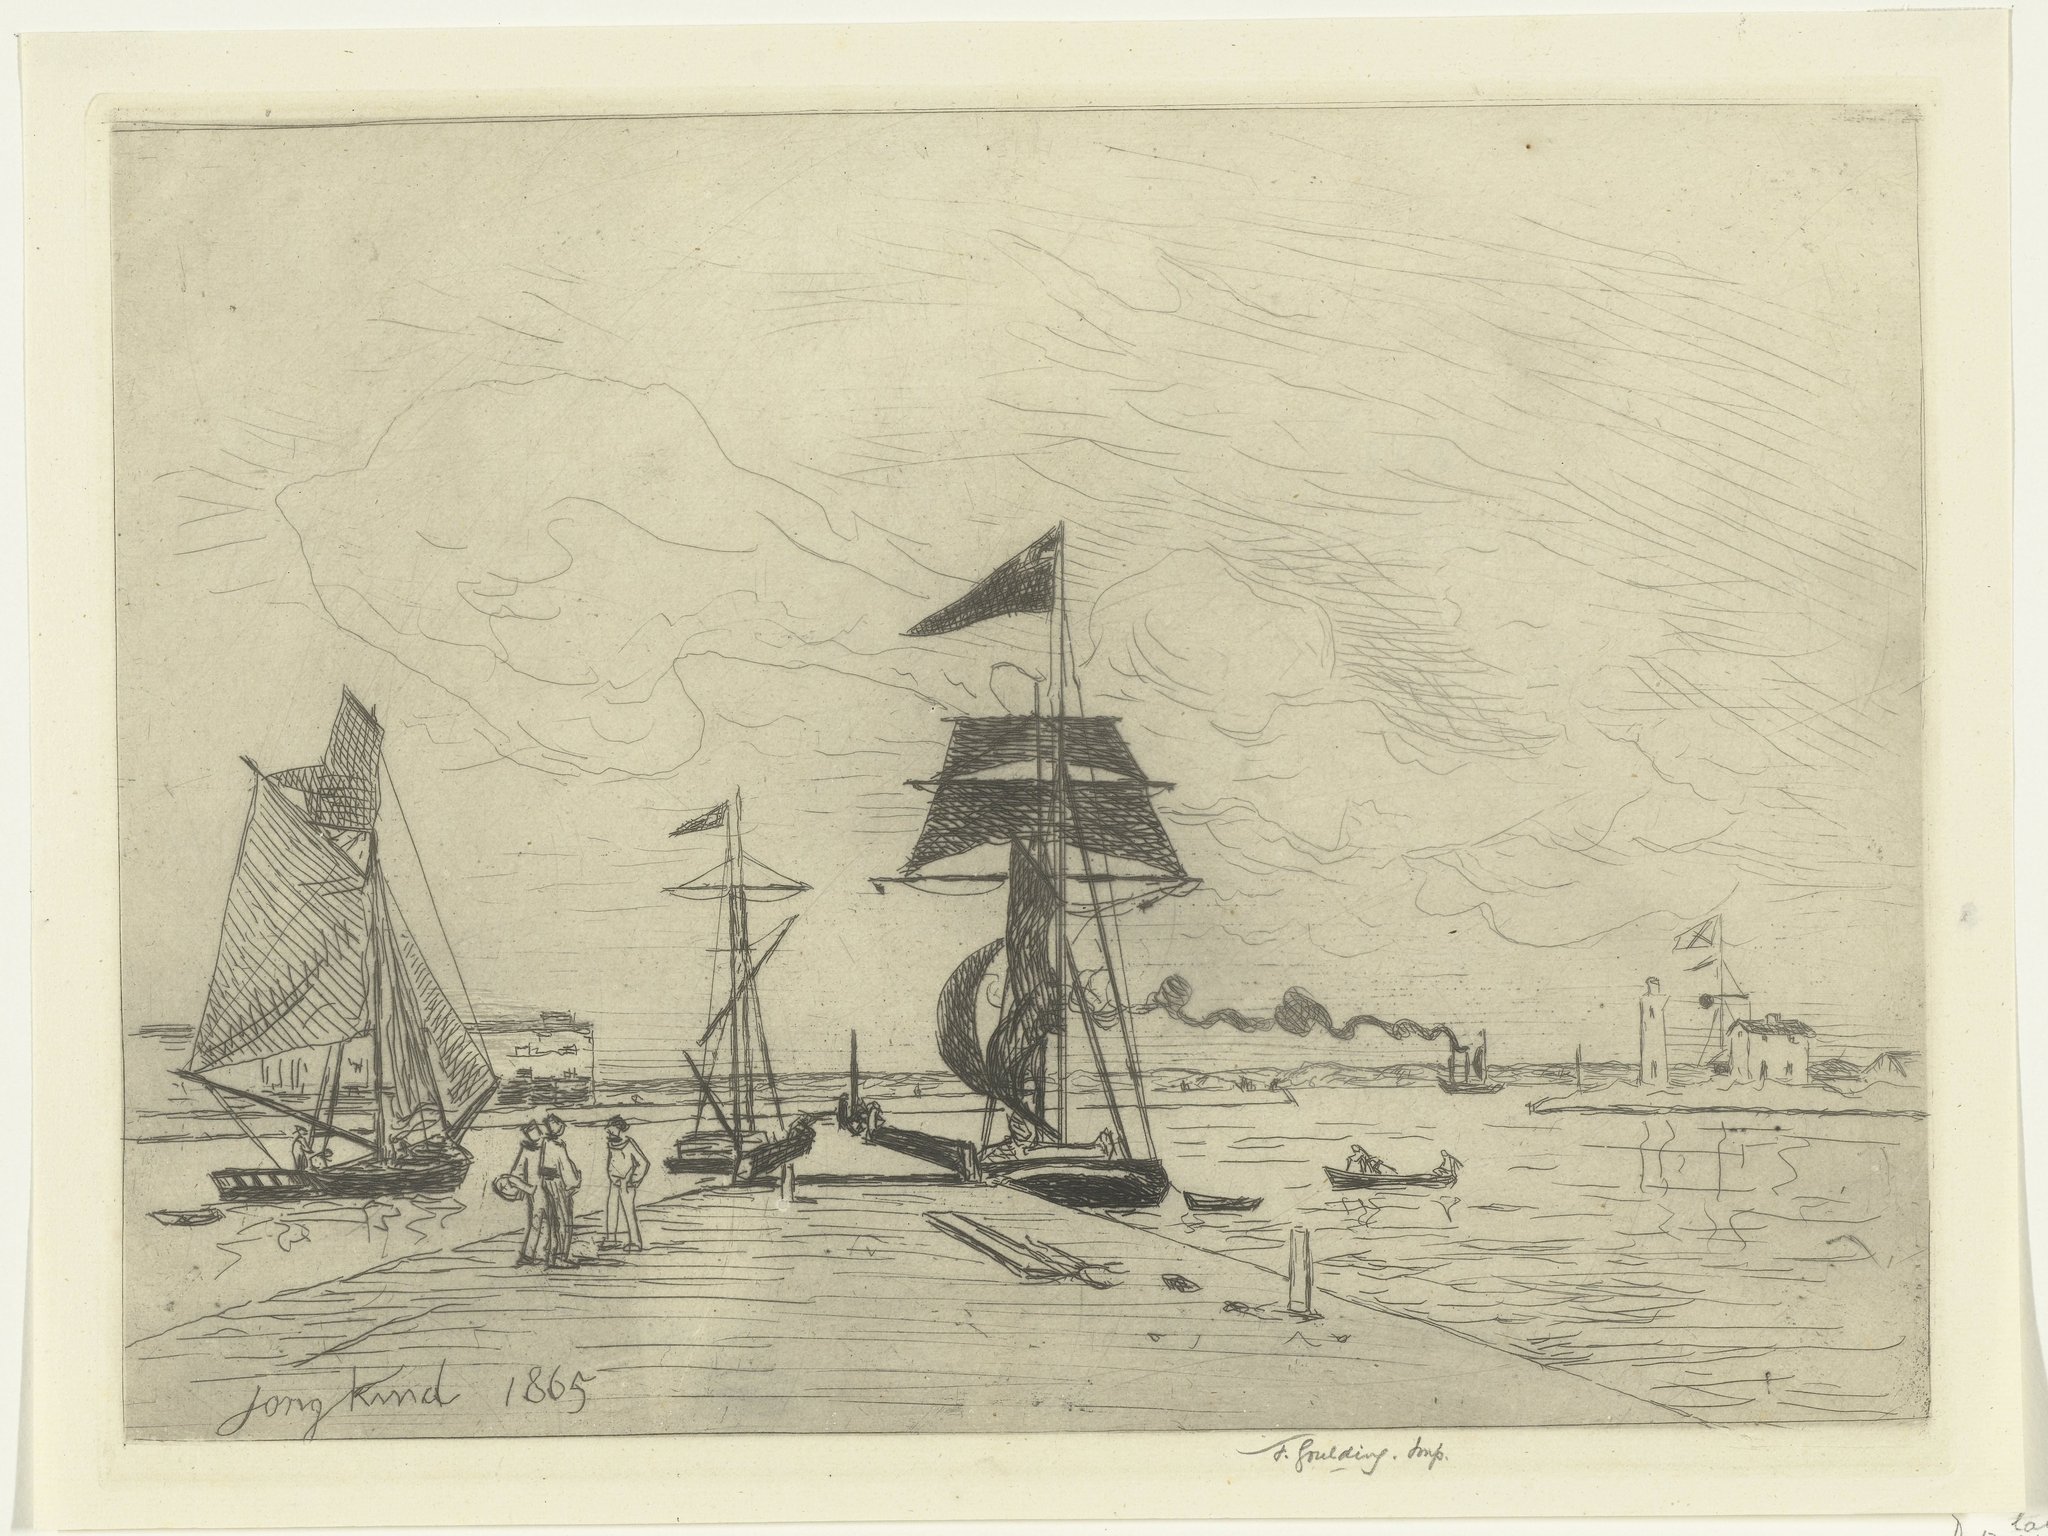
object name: print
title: Aanlegsteiger bij Honfleur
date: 1865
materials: paper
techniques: etching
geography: london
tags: harbour, ships (in general)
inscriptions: collector's mark: Lugt 2228a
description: Een steiger in de haven van Honfleur, waaromheen drie zeilschepen liggen. Rechts op de achtergrond een vuurtoren, links een aantal huizen.